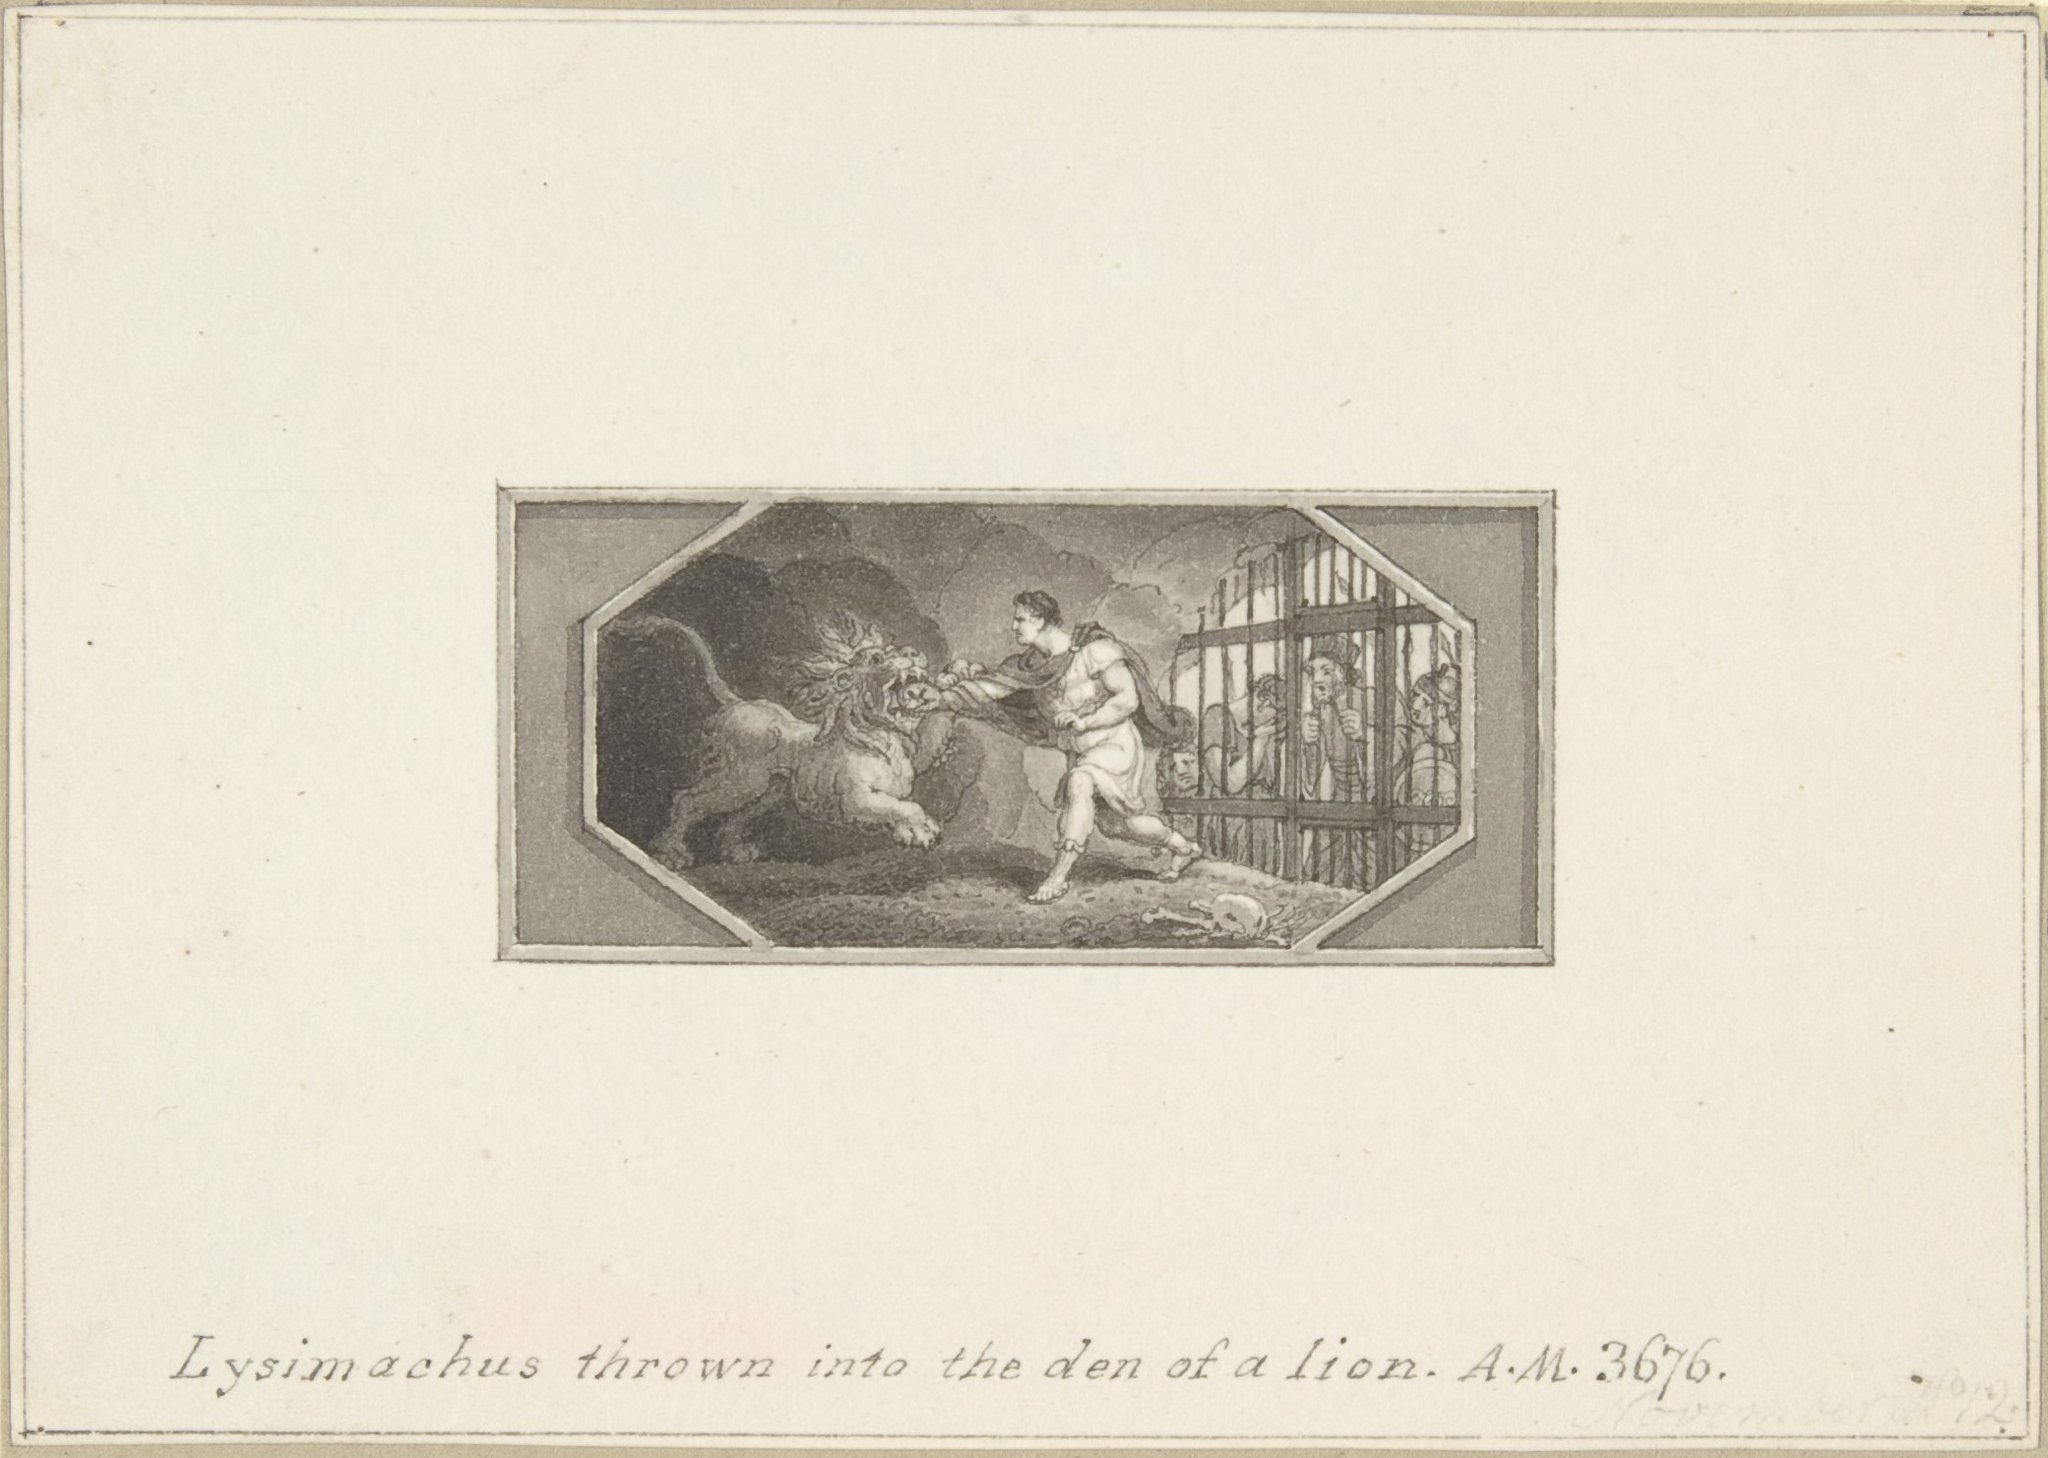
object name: drawing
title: Lysimachus thrown into the Den of a Lion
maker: edward francis burney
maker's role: artist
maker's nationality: british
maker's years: 1760-1848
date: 1790-1800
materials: ink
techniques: brush, pen, wash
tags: prisons,men,lions